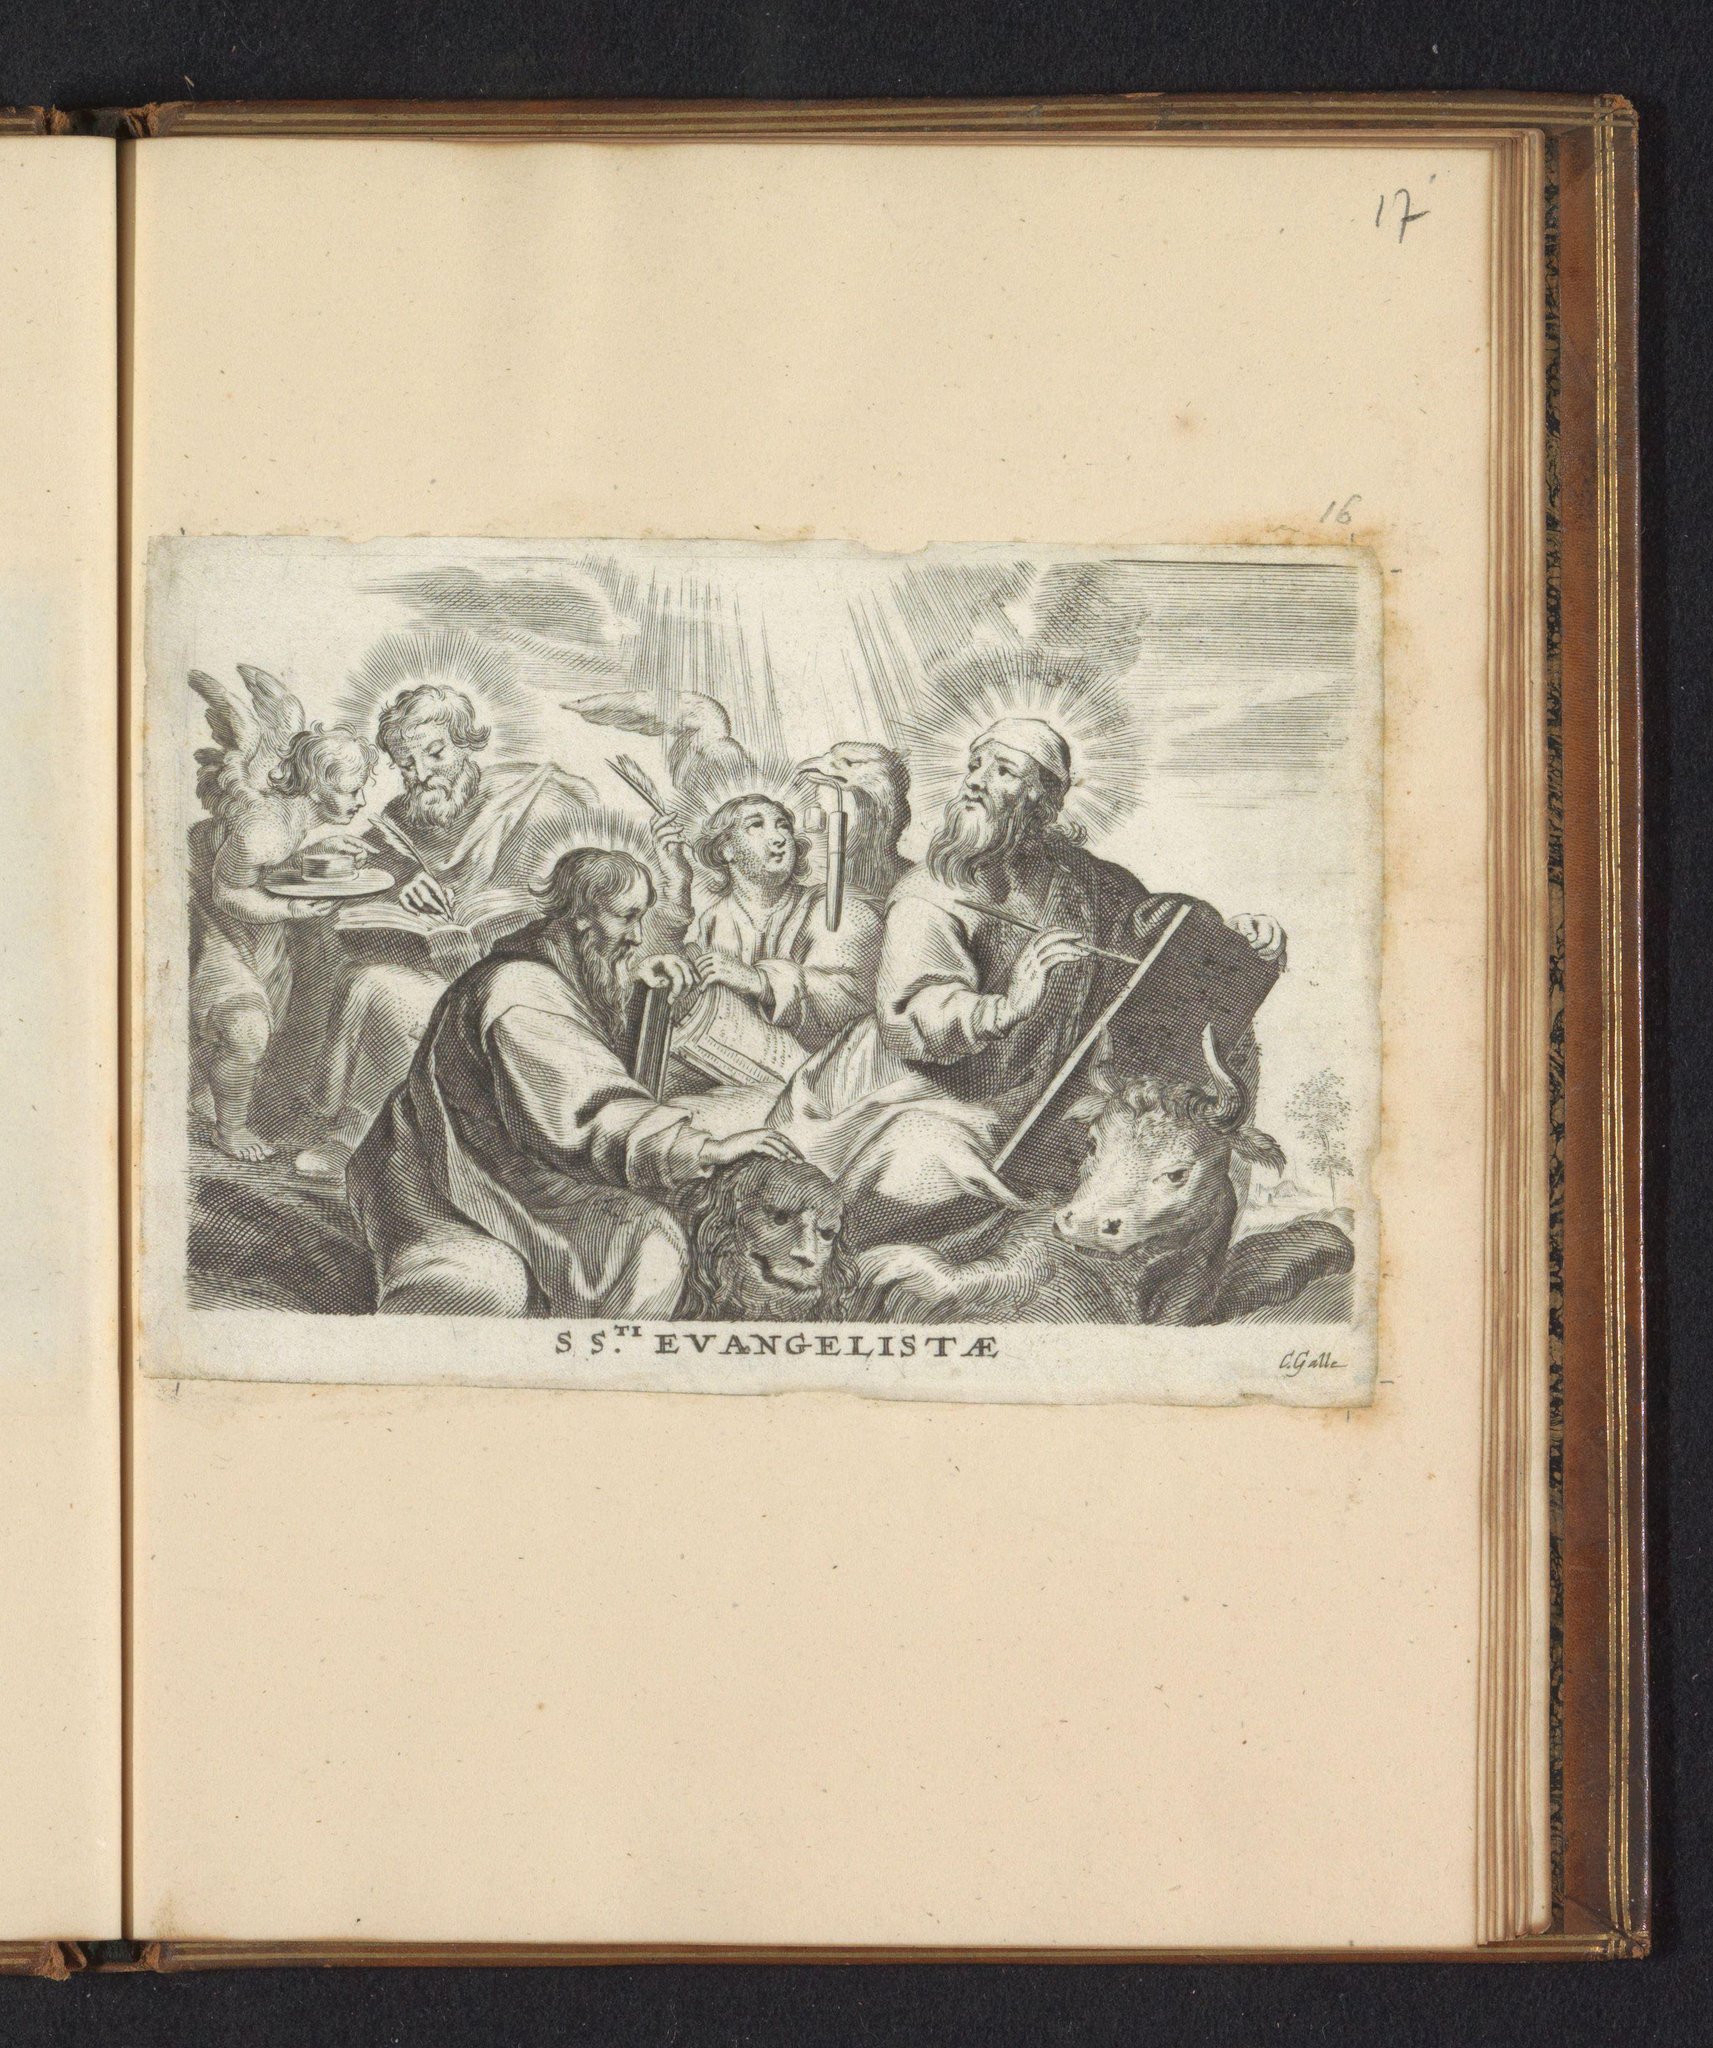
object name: print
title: Vier evangelisten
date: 1640-1678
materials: paper, parchment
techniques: engraving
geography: antwerp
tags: evangelists, usually with books or scrolls (not in biblical context)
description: De vier evangelisten met hun symbolen. Onderdeel van een prentalbum met negentien devotionele prenten op perkament.